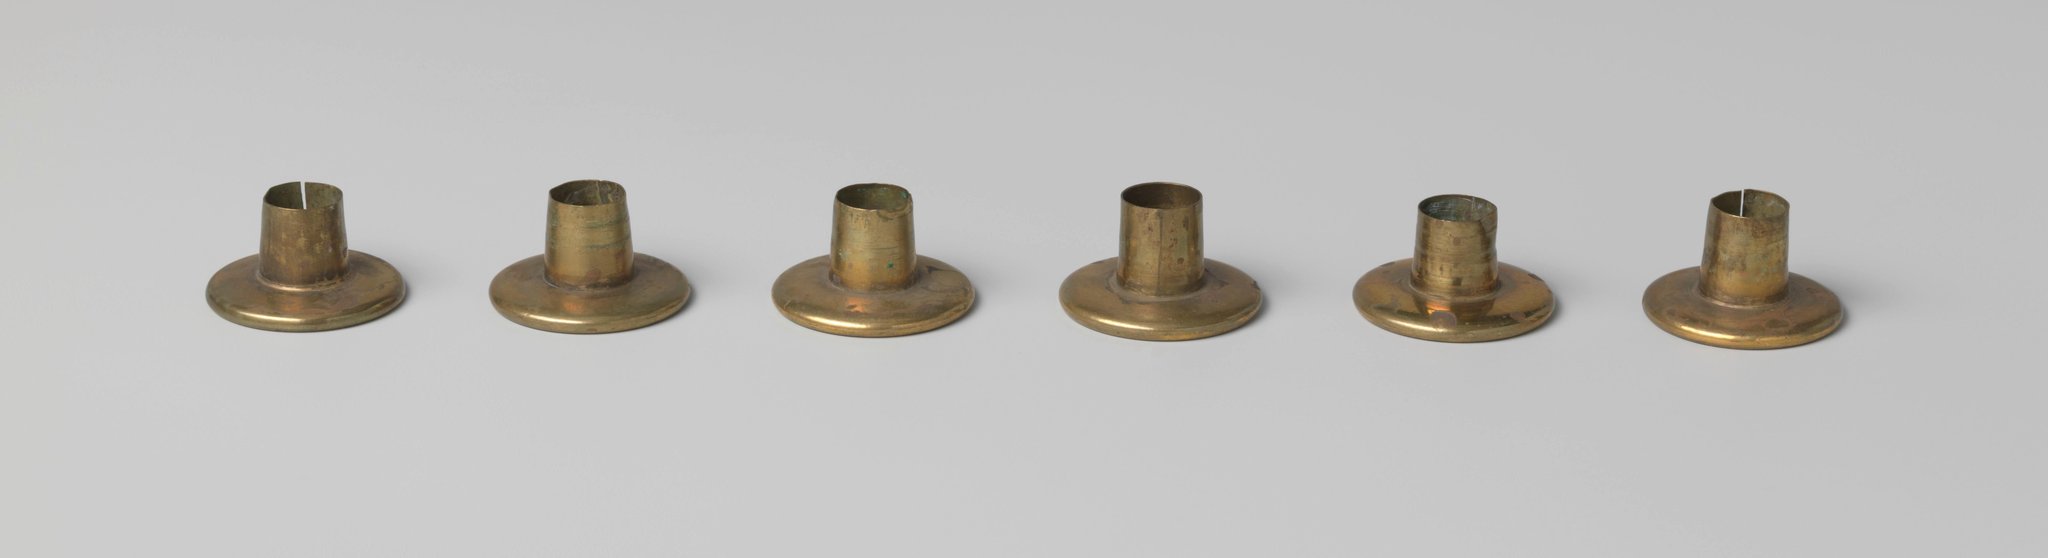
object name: chandelier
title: Zes onderdelen van kroonluchter van verguld brons en veelkleurig beschilderd Meissen porselein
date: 1725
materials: bronze, copper, porcelain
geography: meissen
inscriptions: inscription: ‘N5 ; N7 ; N8 ; N13’, date, inscription, inscription: ‘BvGH’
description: Kroonluchter met veelkleurig beschilderd Meissen porselein. De kroon bestaat uit een balustervormige stam en zes armen, die gestoken zijn in zes ronde gaten in de koperen plaat, die het schaalvormige balusterdeel aan de bovenkant afsluit. De stam bestaat uit porselein, verguld brons en onversierd koper. De armen met kaarsenhouders en vetvangers zijn van porselein. De porseleinen delen van de armen en de stam zijn beschilderd met Indinische Blumen. De kroon is gemerkt.